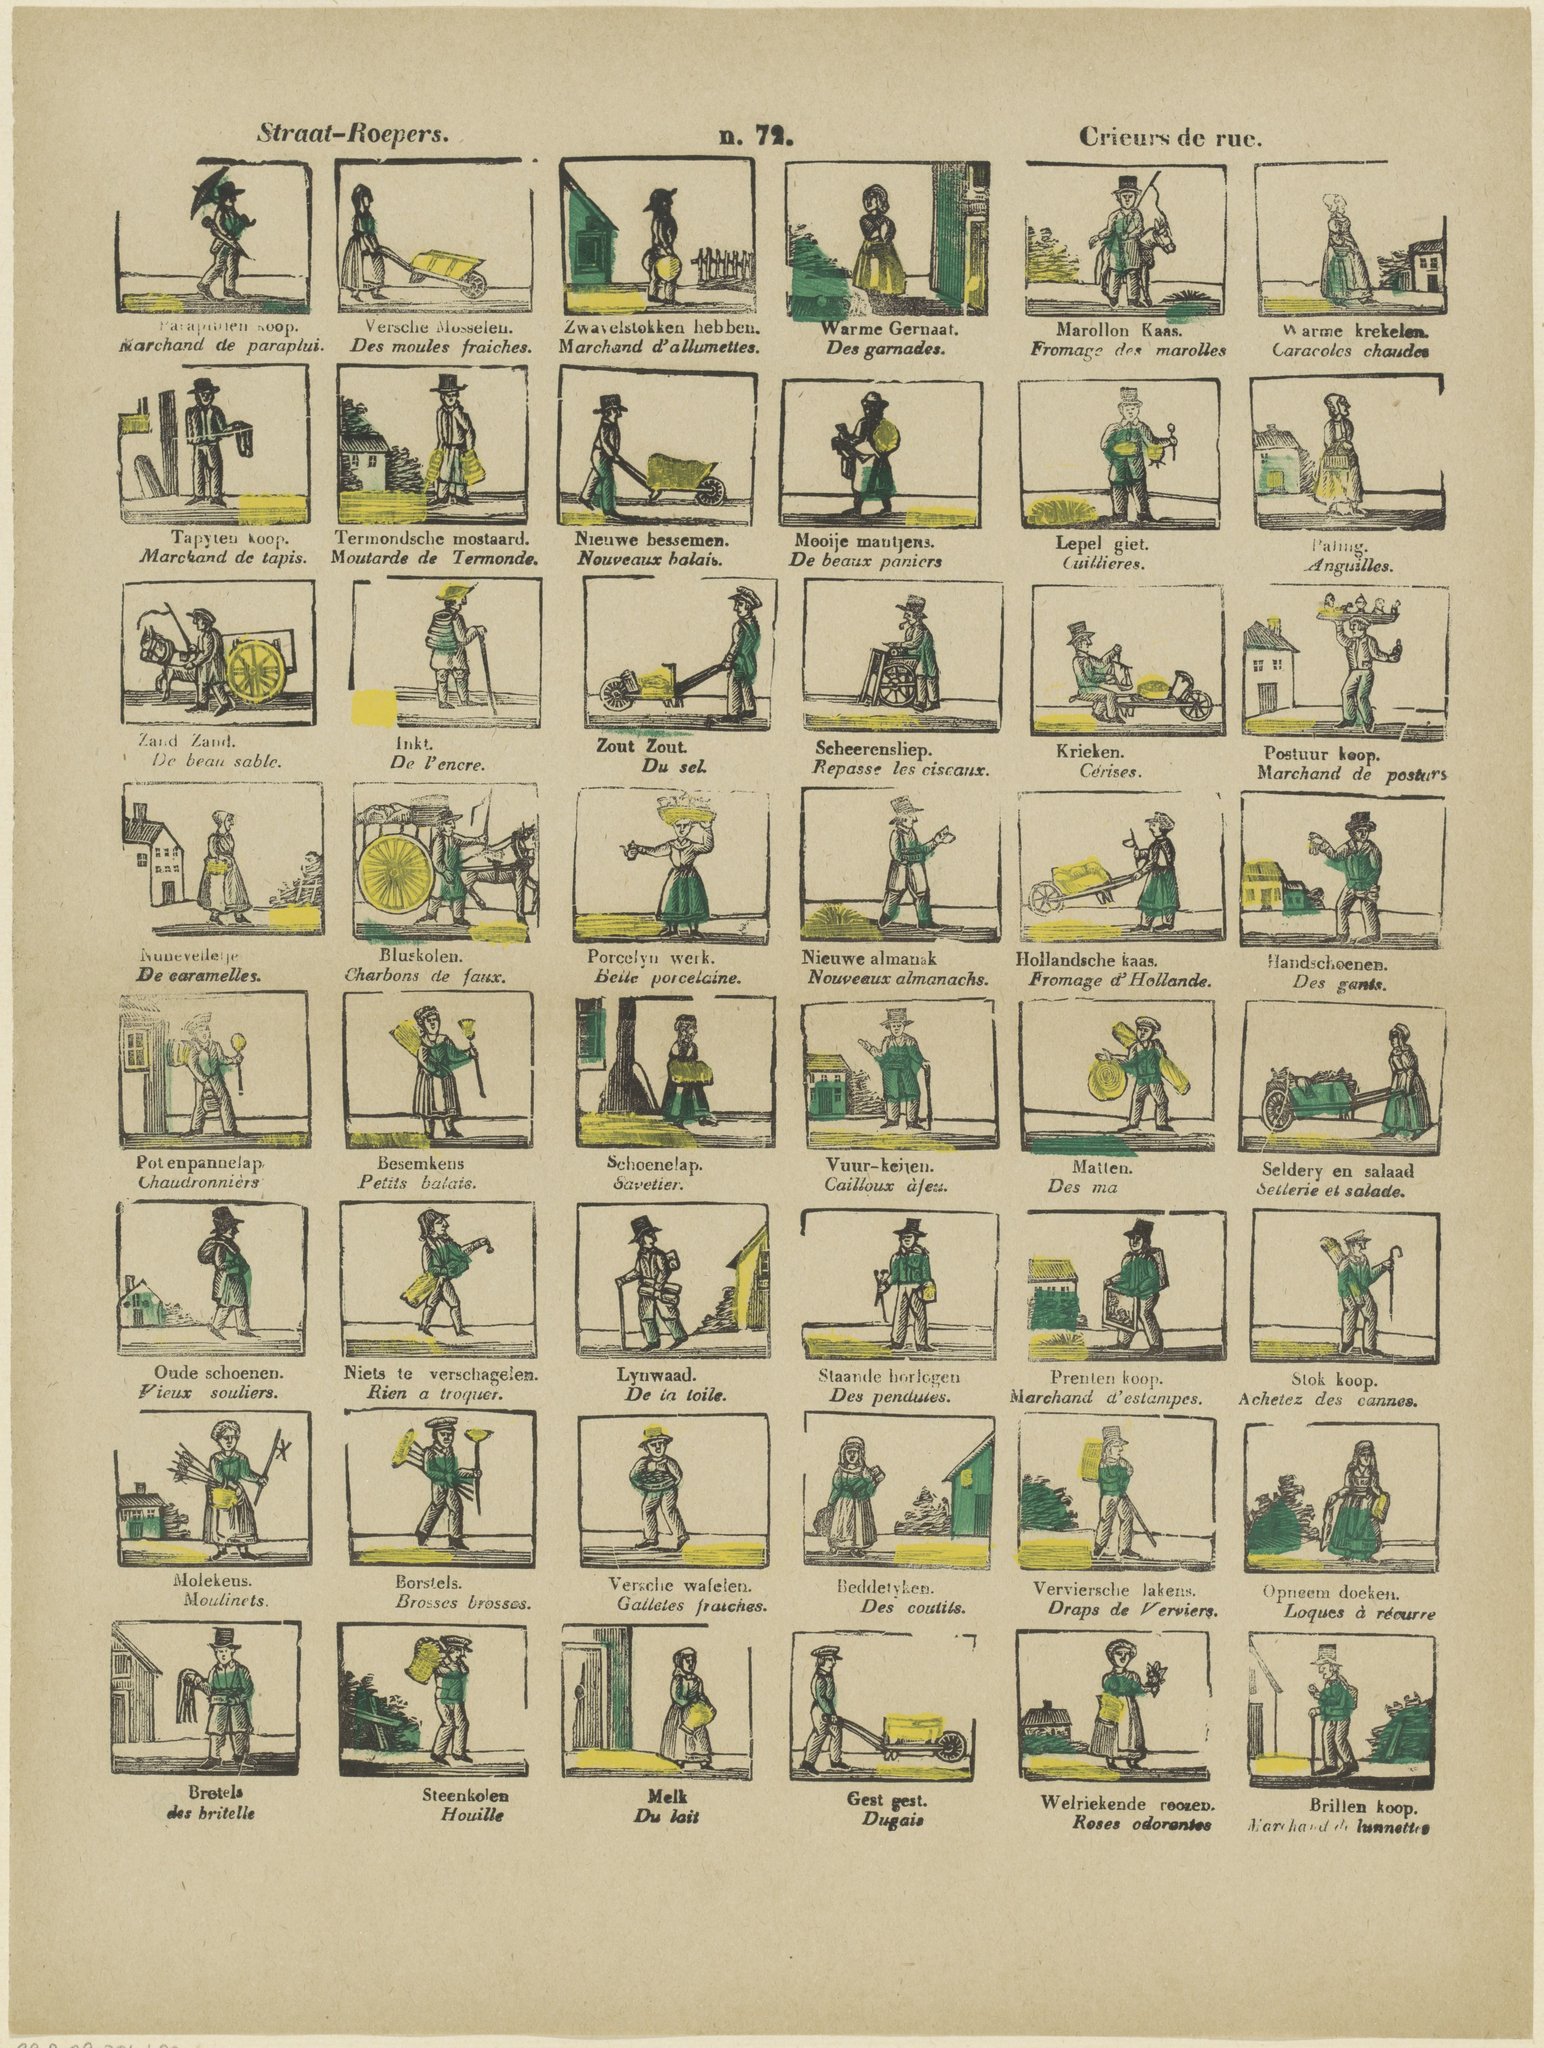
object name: popular print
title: Straat-roeper / Crieurs de rue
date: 1866-1902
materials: paper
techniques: colour, letterpress printing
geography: turnhout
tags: street-trader, merchant, salesman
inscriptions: collector's mark: Lugt 2760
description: Blad met 48 voorstellingen van straatverkopers, zoals een bezemverkoper, een kaasverkoper en een rozenverkoopster. Onder elke afbeelding een onderschrift in het Nederlands en in het Frans. Genummerd midden boven: n. 72.